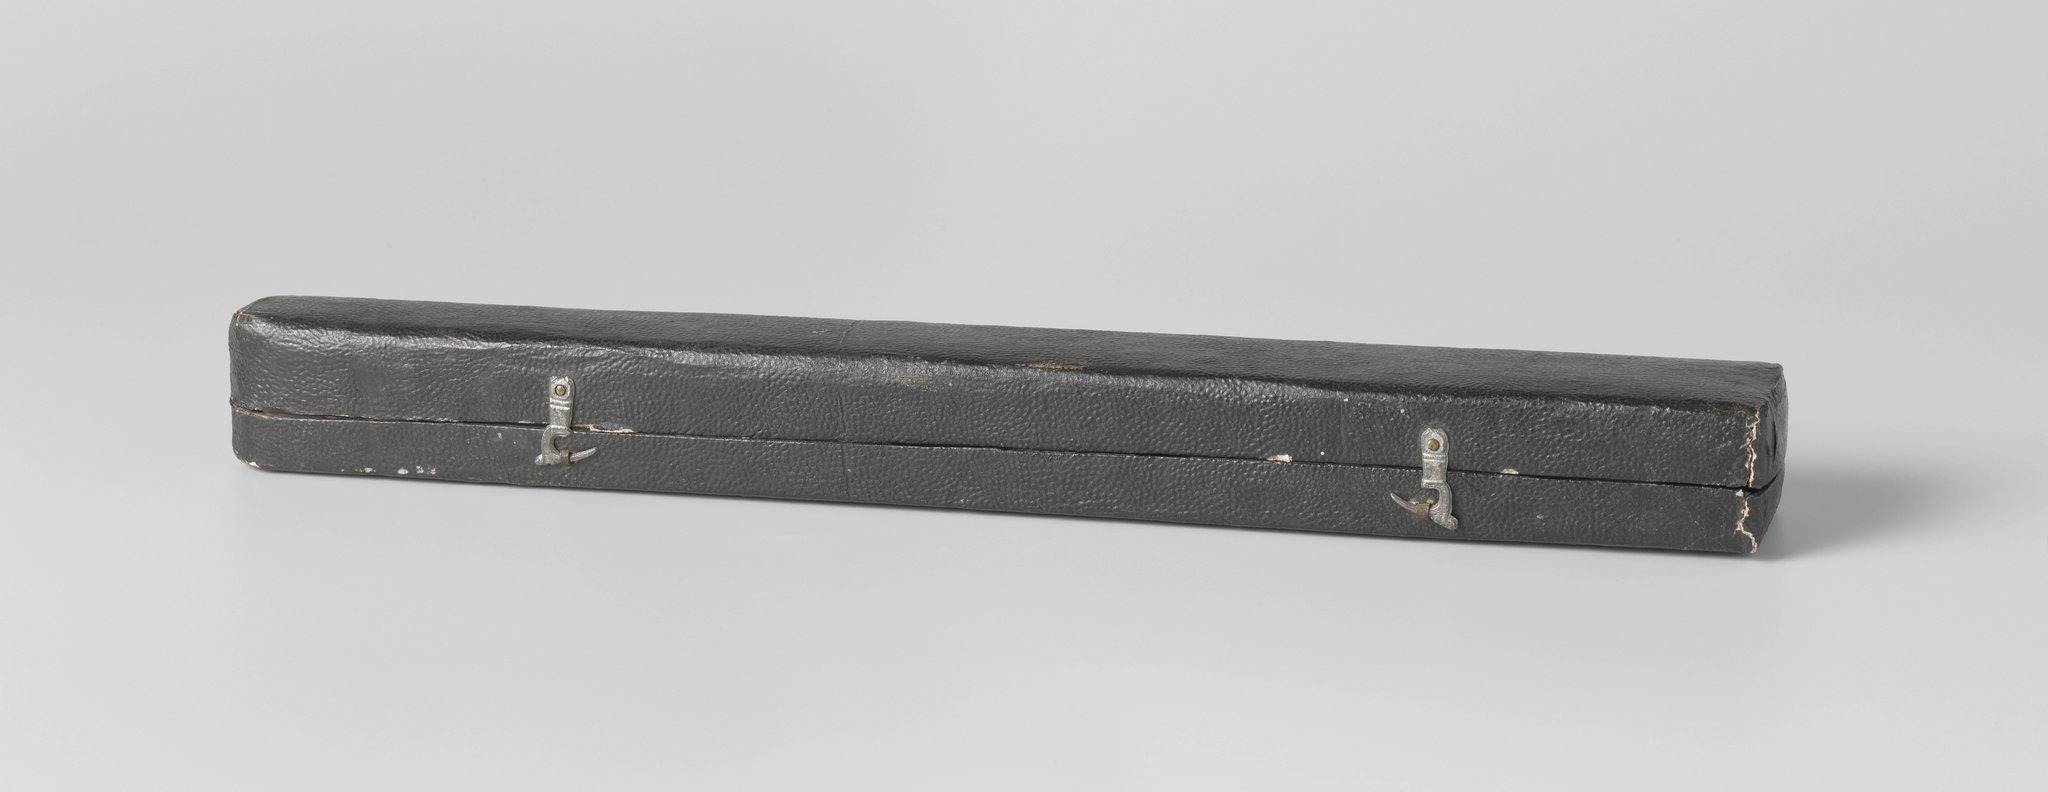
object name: waaierdoos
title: Waaierdoos, taps toelopend, beplakt met zwart papier en gevoerd met blauw papier, sluiting met twee loden haken en ogen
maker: Anonymous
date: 1784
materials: lead, paper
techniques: casting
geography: netherlands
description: Waaierdoos, taps toelopend, beplakt met zwart papier en gevoerd met blauw papier. Sluiting met twee loden haken en ogen. 'Scharnieren' van grof linnen verbinden deksel en onderkant.